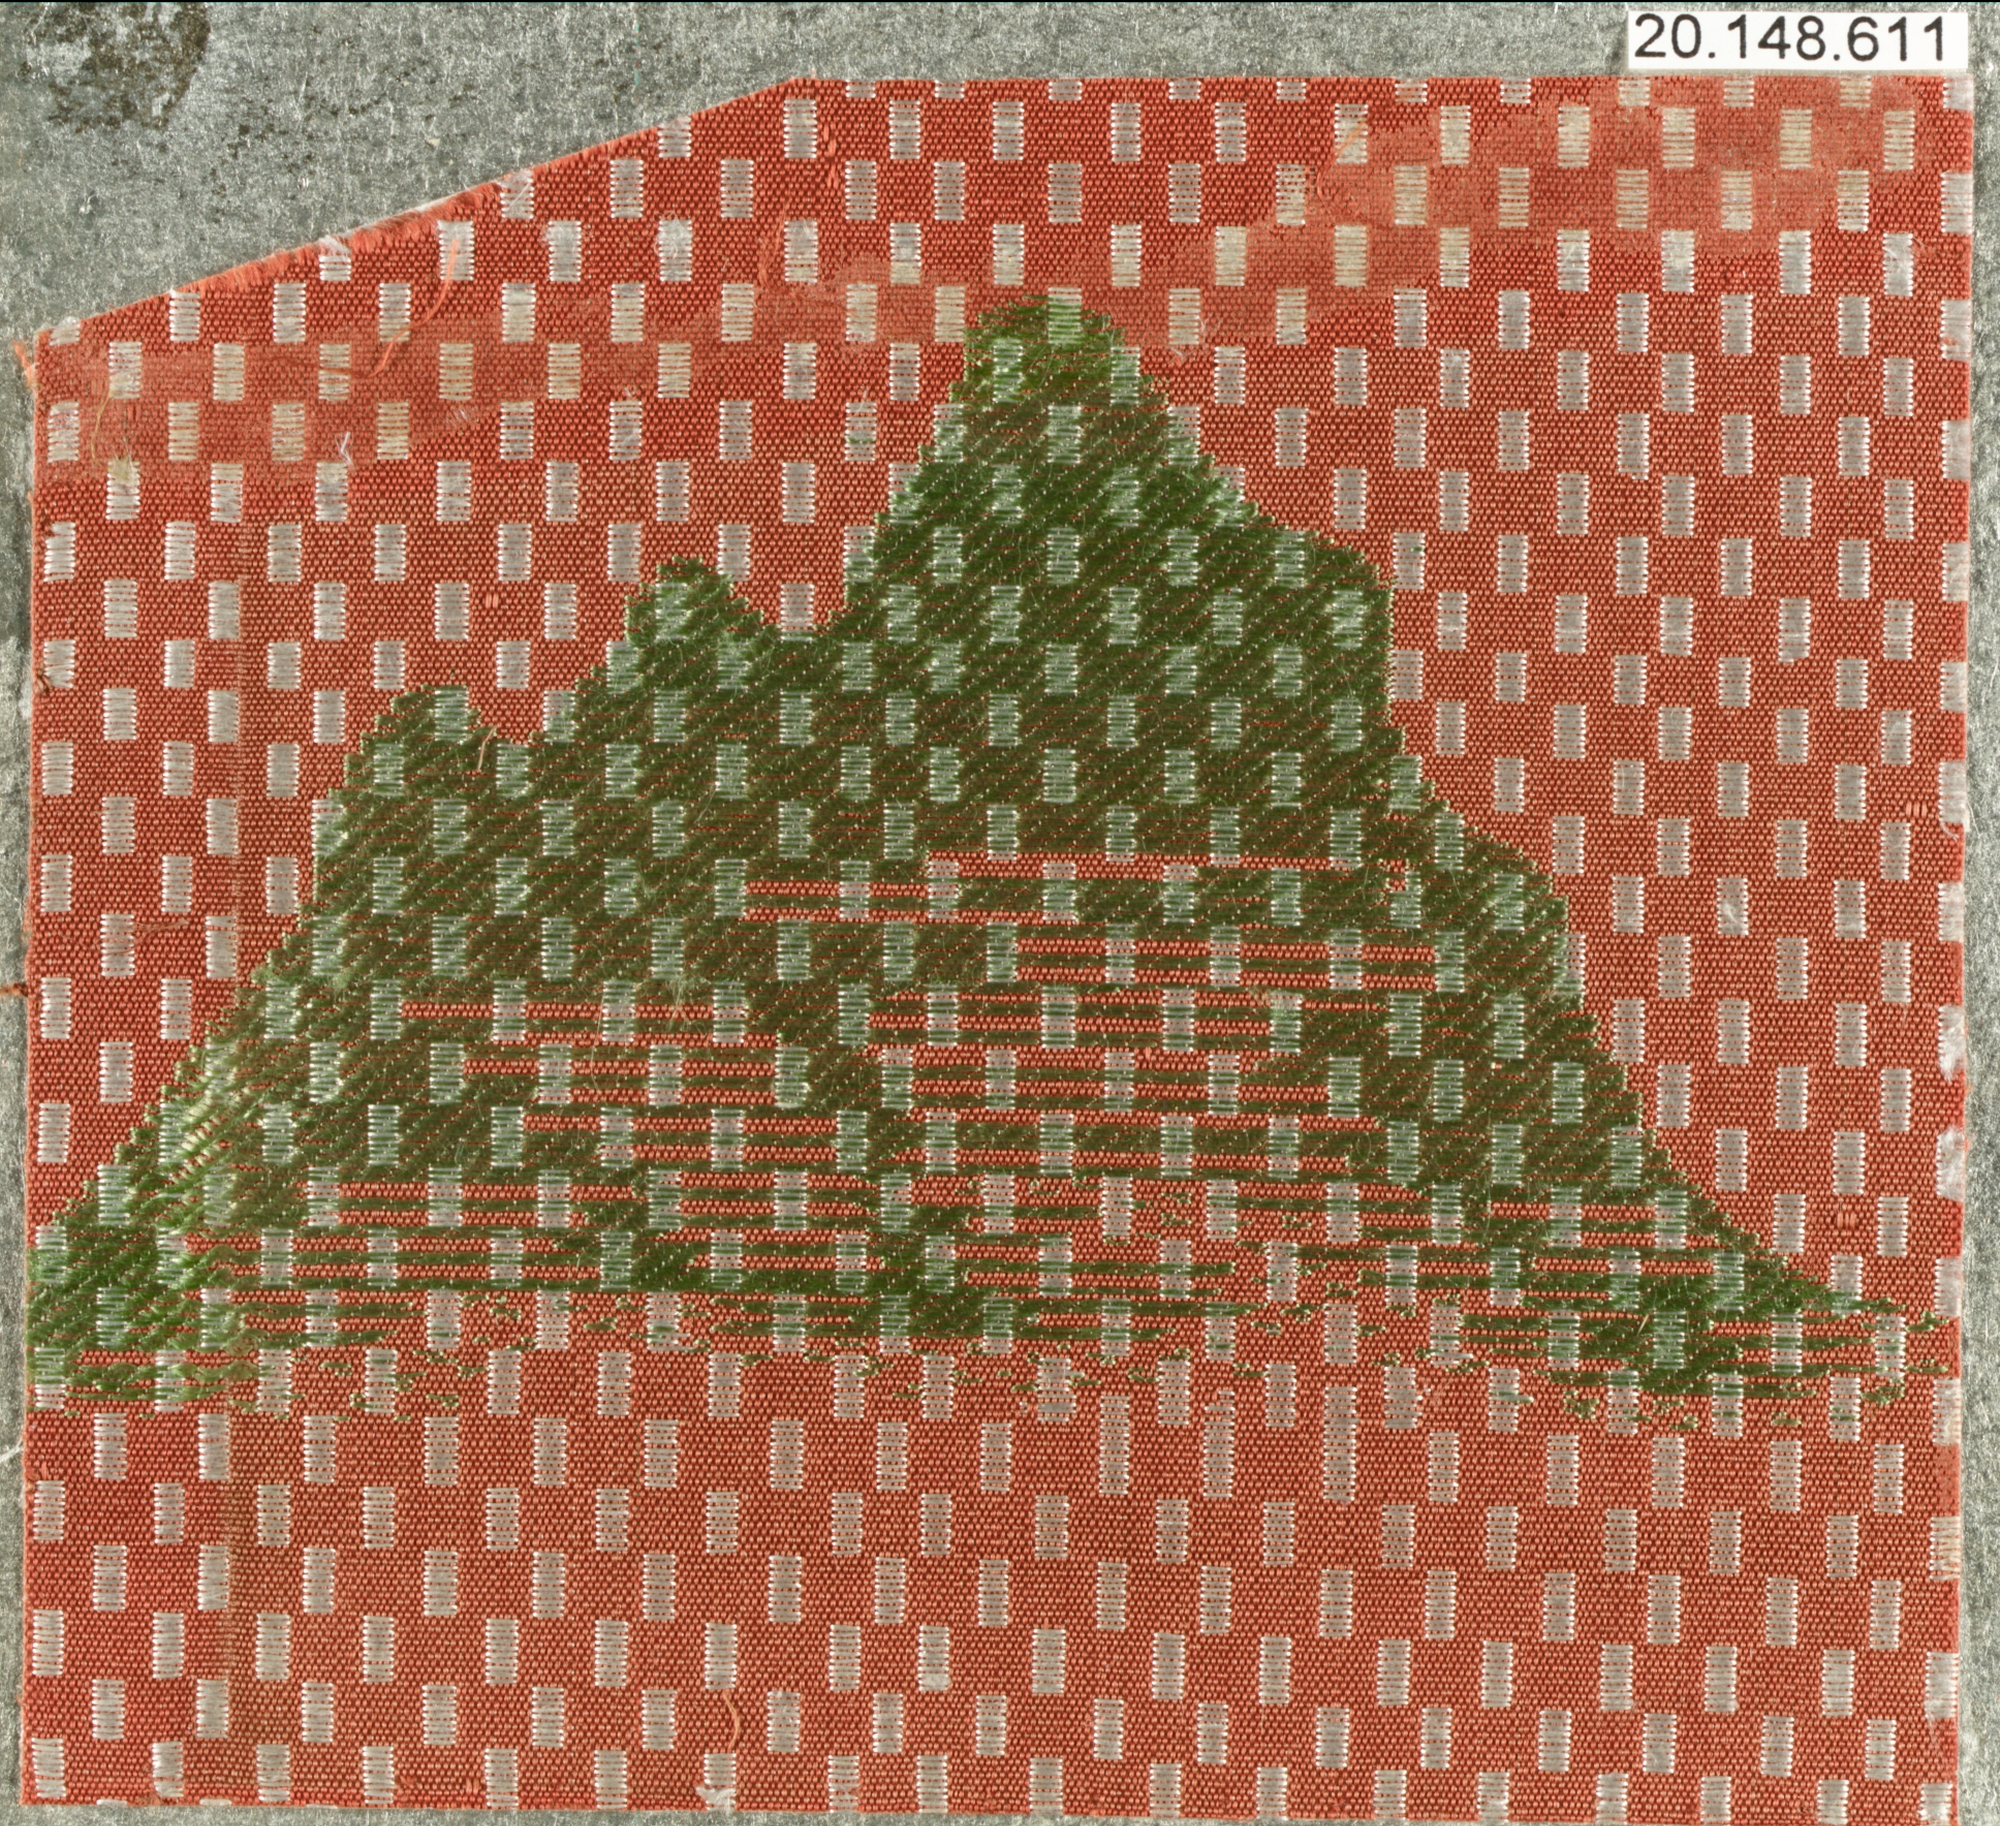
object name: piece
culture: japanese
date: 1801-1900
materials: silk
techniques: compound weave